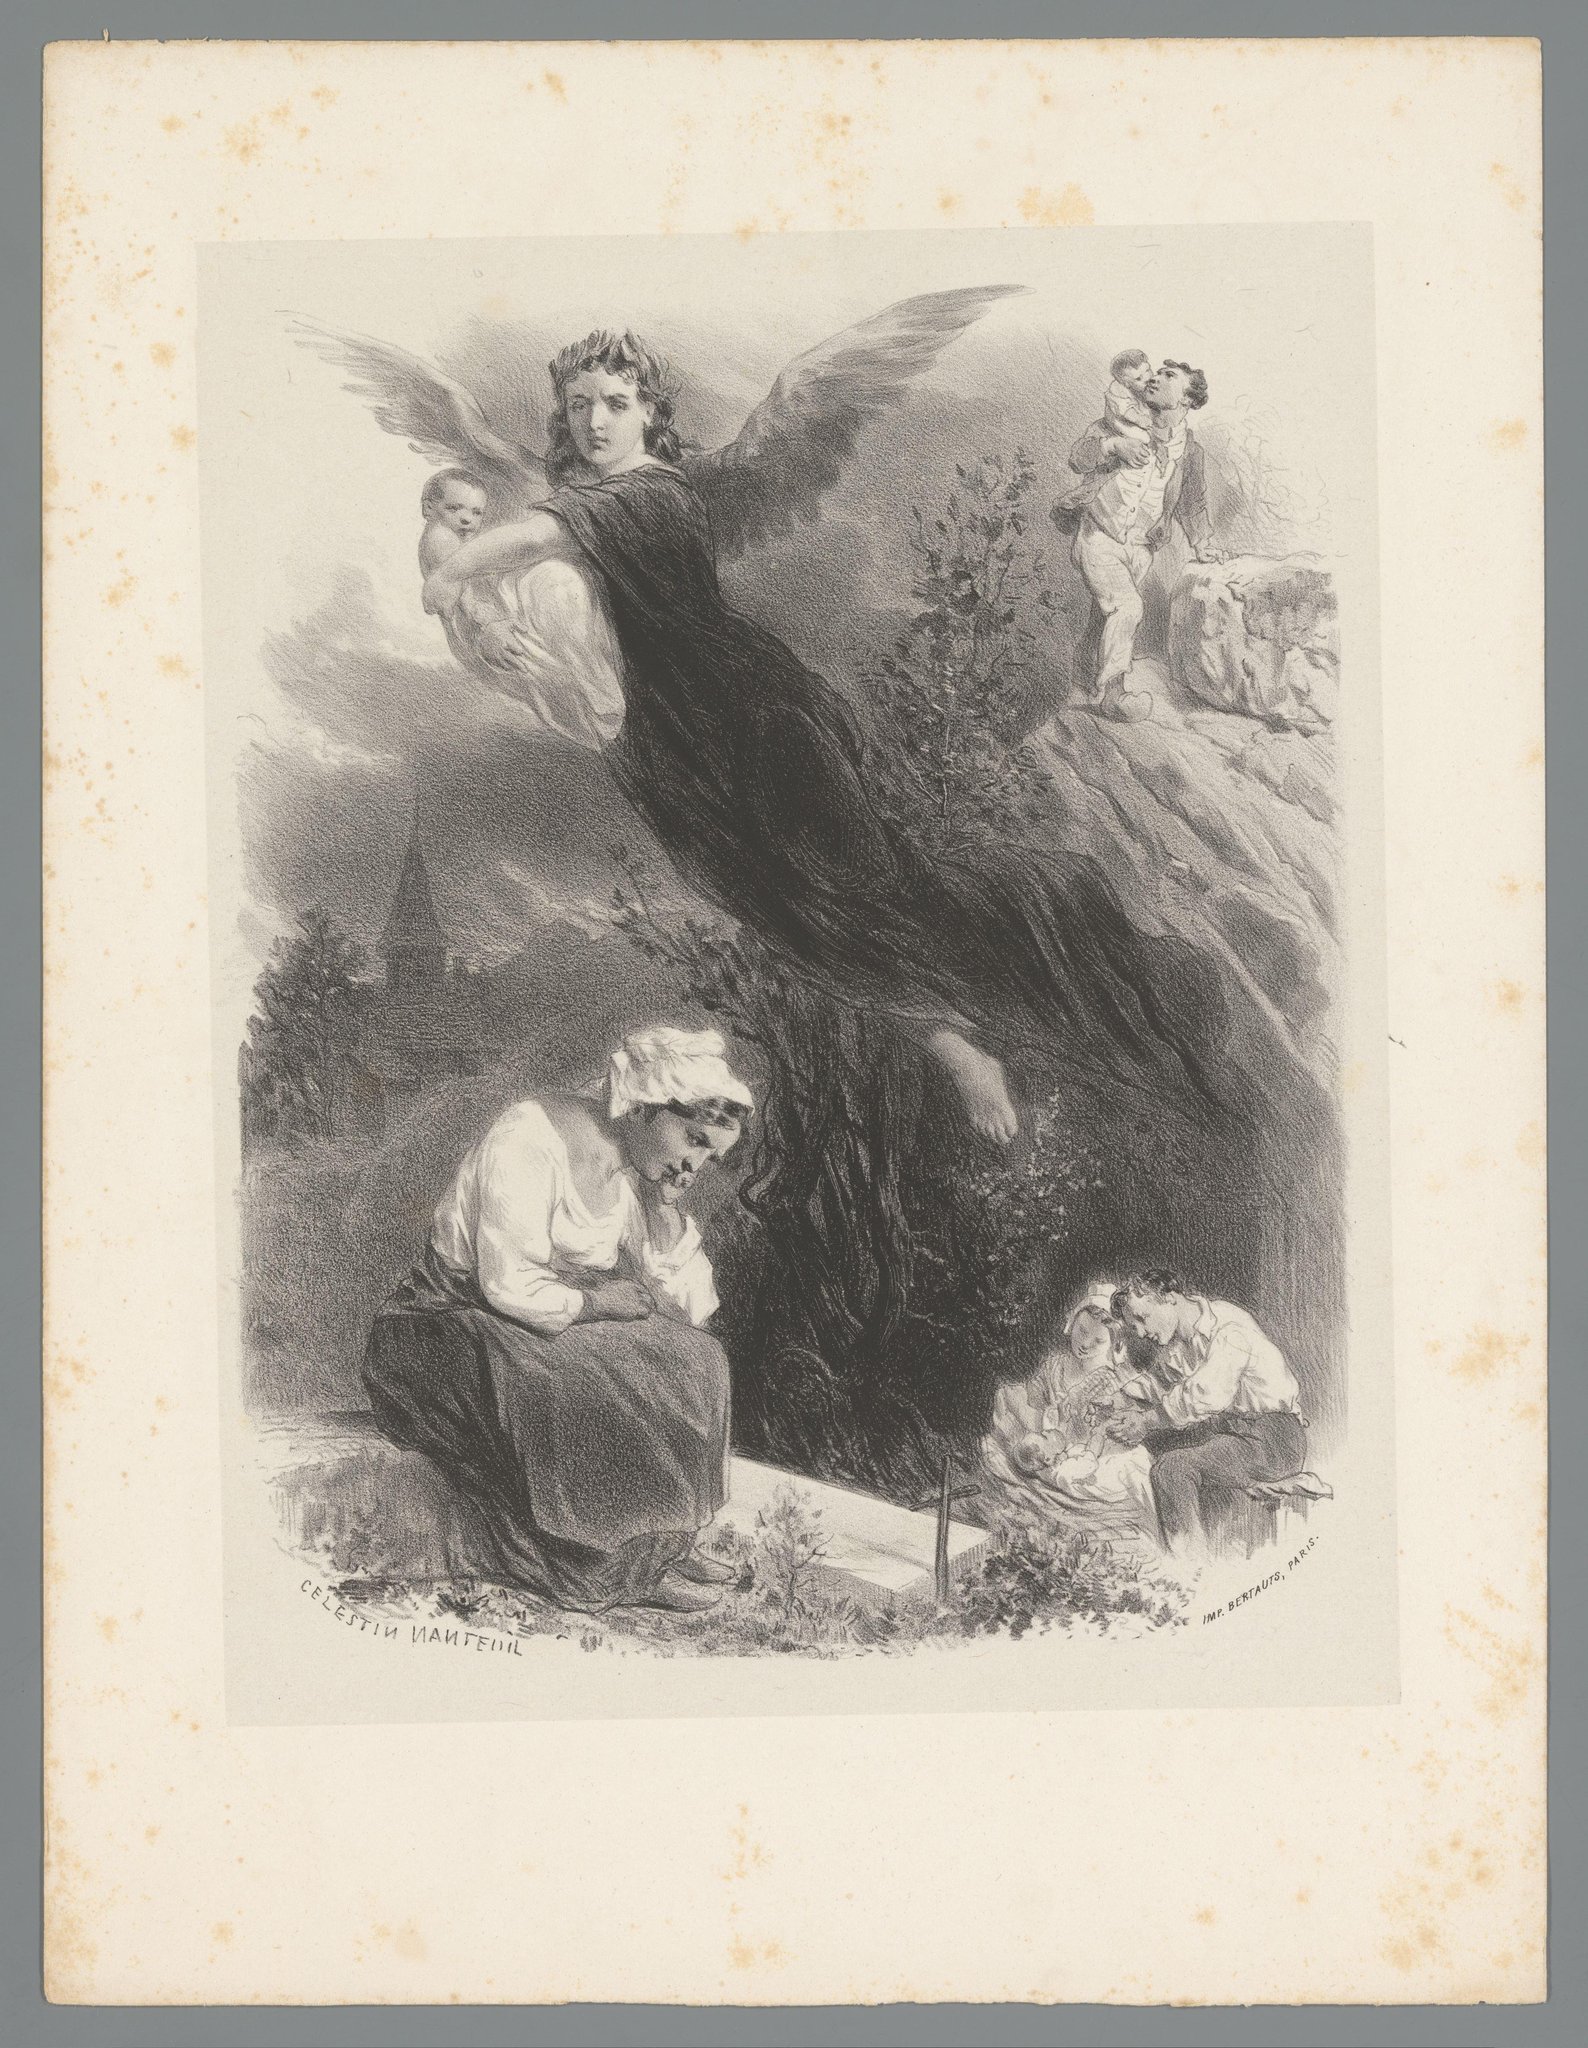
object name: print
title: Korte levensloop van een overleden baby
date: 1826-1880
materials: paper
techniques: lithograph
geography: paris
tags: death of a child, grave, tomb, mourning the dead, infant, baby, angels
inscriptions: collector's mark: Lugt 964